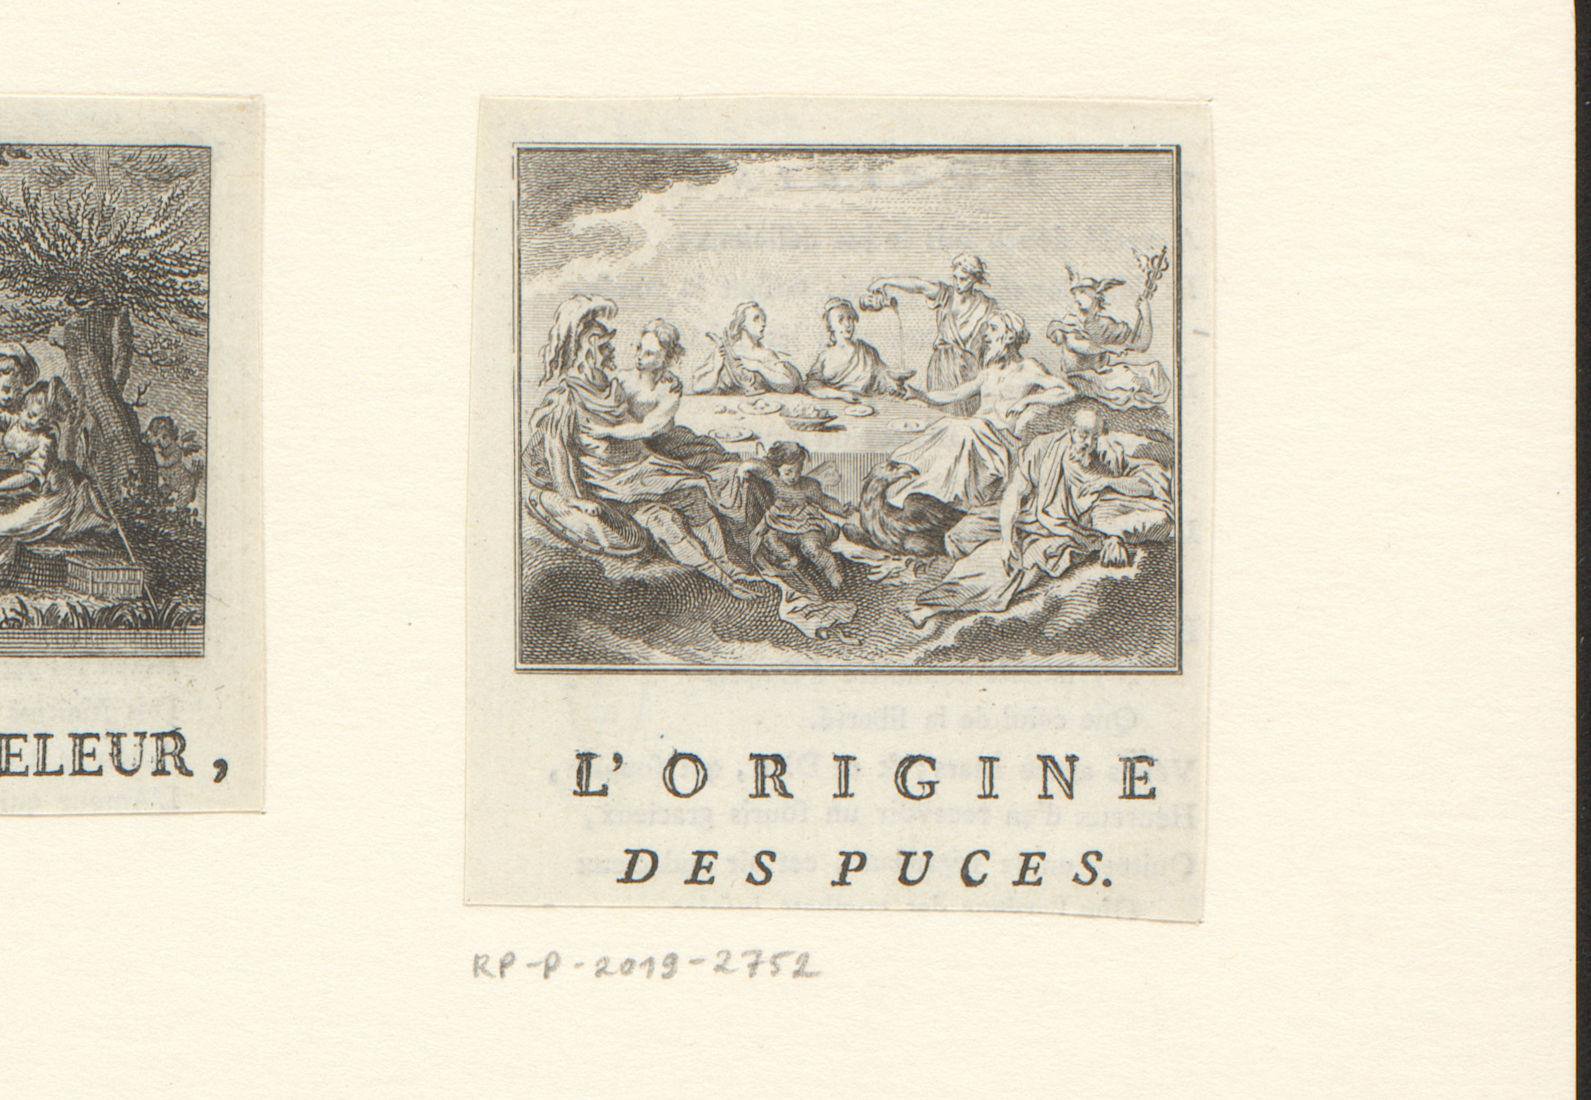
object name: print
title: Goden aan tafel op de Olympus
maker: Anonymous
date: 1763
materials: paper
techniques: engraving, etching, letterpress printing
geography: france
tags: olympus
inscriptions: collector's mark: Lugt 2228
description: Mogelijk prent uit: Grecourt, Jean Baptiste Joseph Willart de. Oeuvres diverses de M. de Grécourt, nouvelle édition, augmentée d'un grand nombre de pièces, revus sur les originales et du Philotanis. Amsterdam: s.n., 1763.